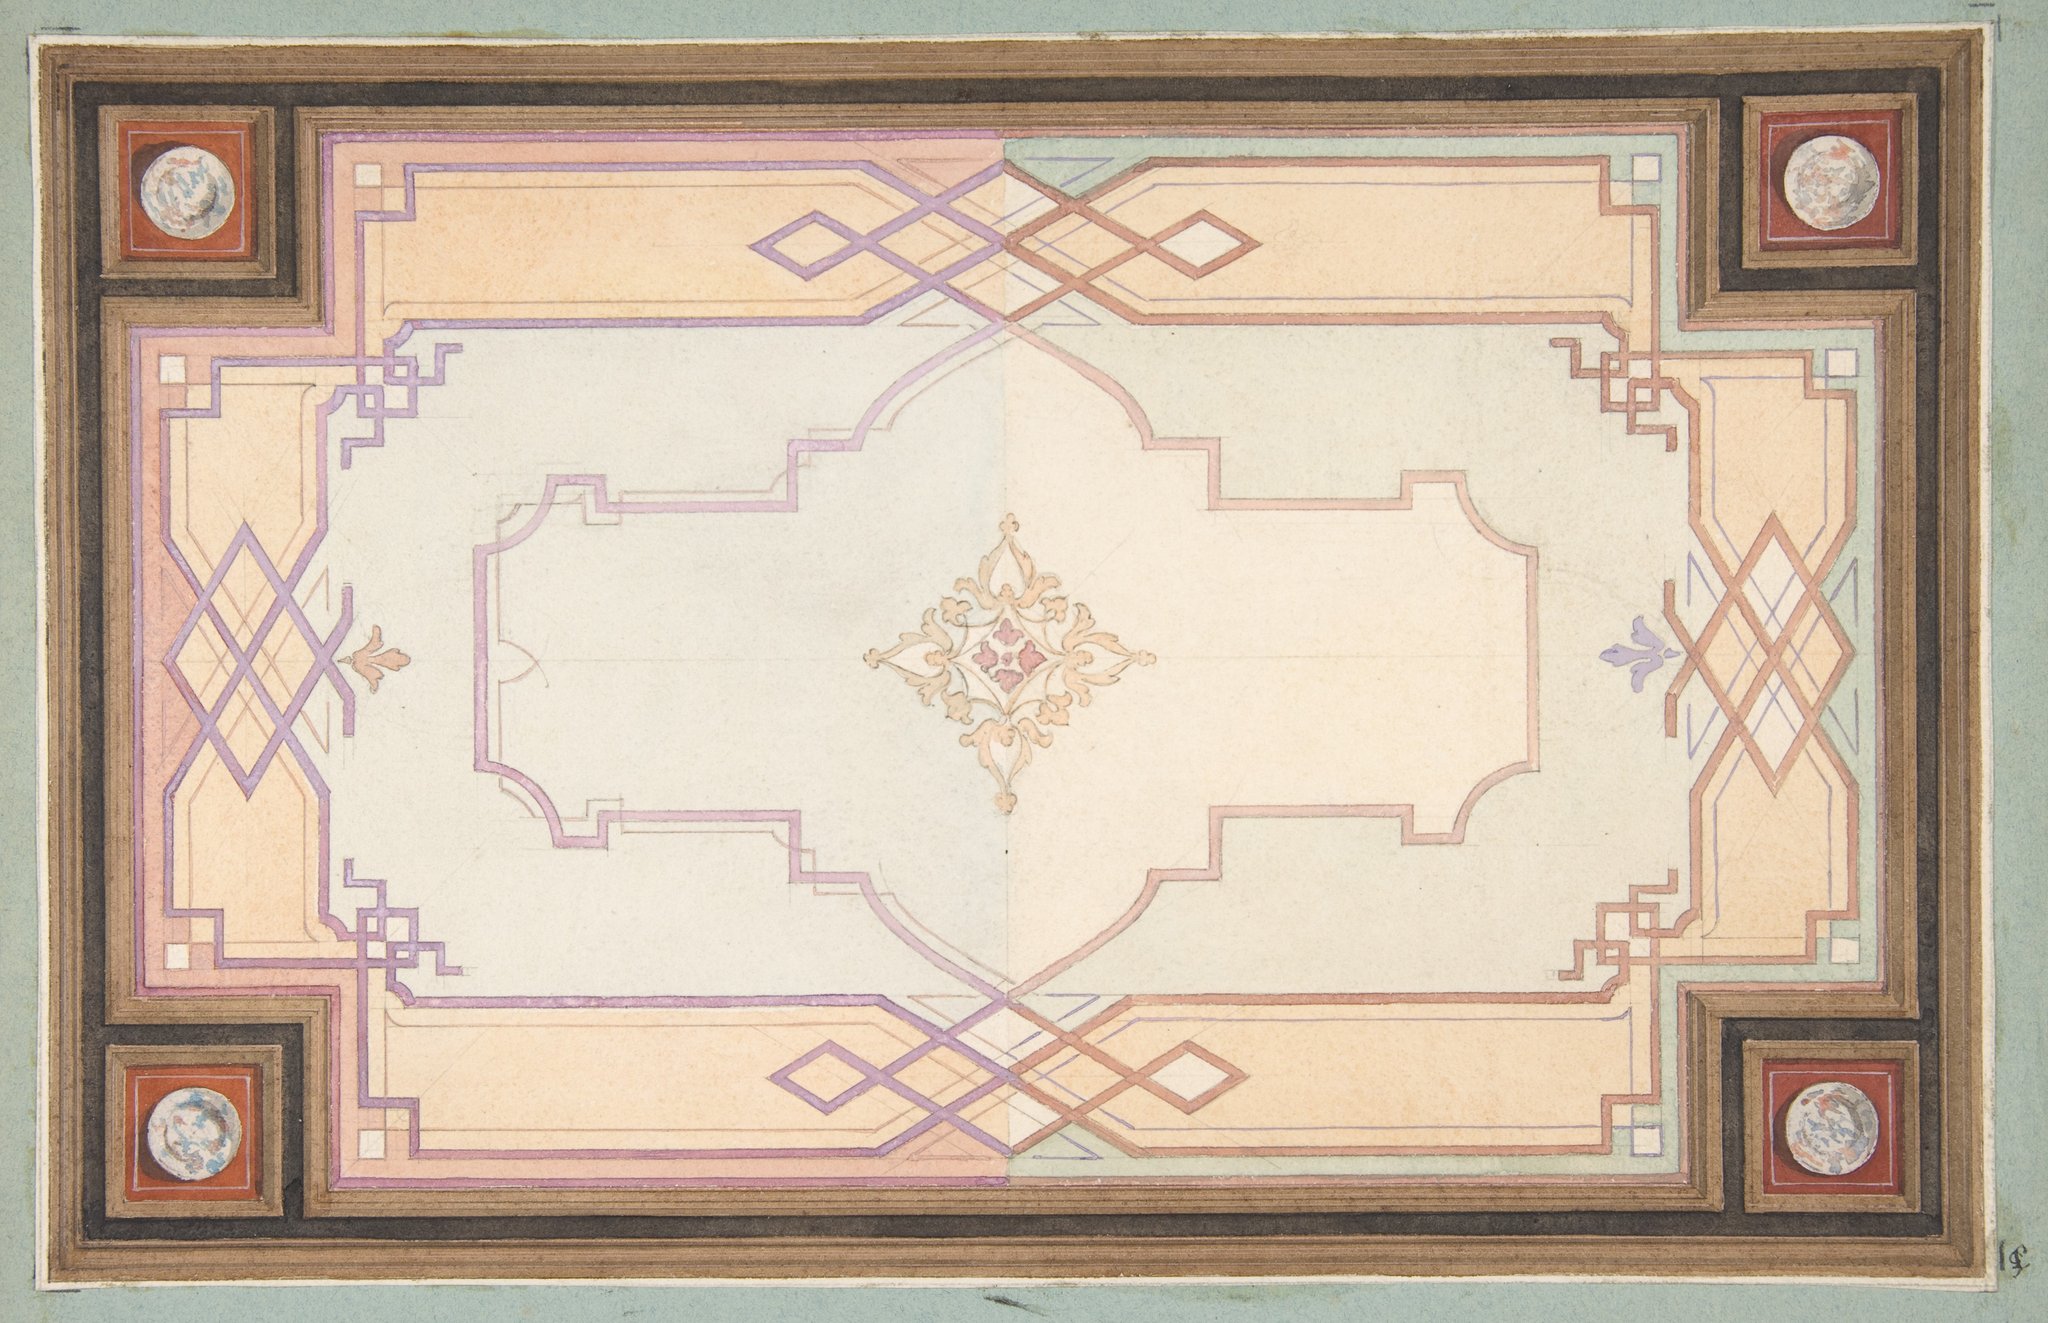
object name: drawing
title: Design for a ceiling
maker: jules-edmond-charles lachaise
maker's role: artist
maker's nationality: french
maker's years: 1897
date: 1851-1900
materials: graphite, watercolor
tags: ceilings